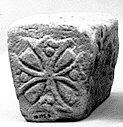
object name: voissoir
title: Block from an Arch with a Cross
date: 501-700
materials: stone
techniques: carving, relief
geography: egypt